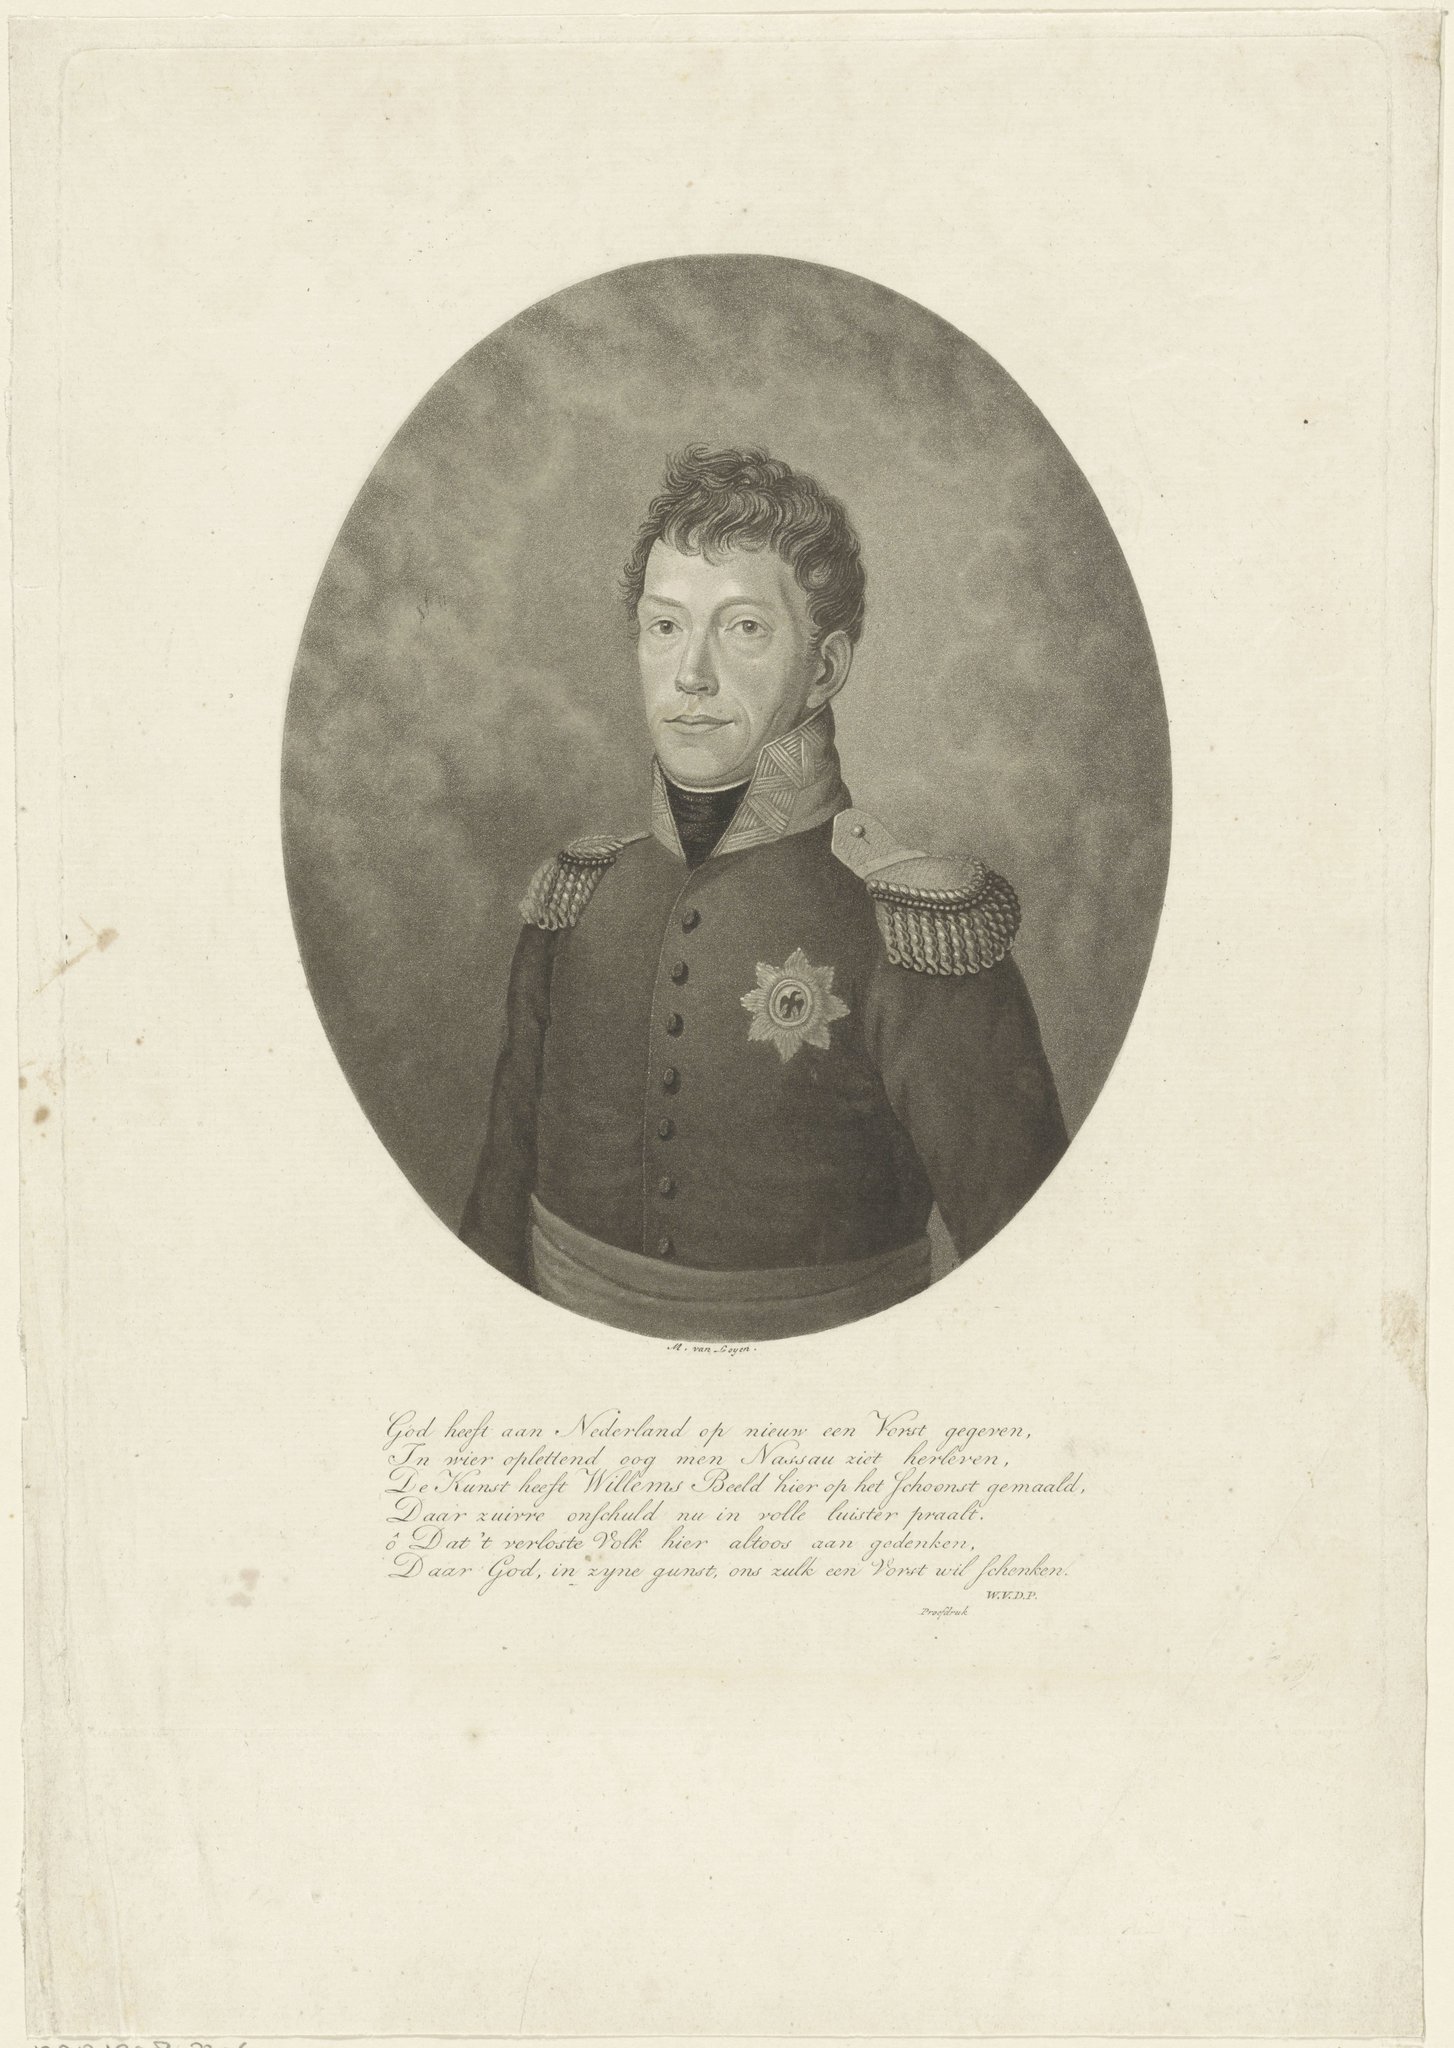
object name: print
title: Portret van Willem I Frederik, koning der Nederlanden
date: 1815-1899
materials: paper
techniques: aquatint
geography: amsterdam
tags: the hague, berlin, william i of the netherlands, knighthood order (with name) - insignia of a knighthood order, e.g.: badge, chain (with name of order)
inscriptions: collector's mark: Lugt 2228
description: De hier vermelde titel verwijst naar de hoogst verkregen titel van de geportretteerde, niet per se naar de titel die de geportretteerde op deze voorstelling draagt.